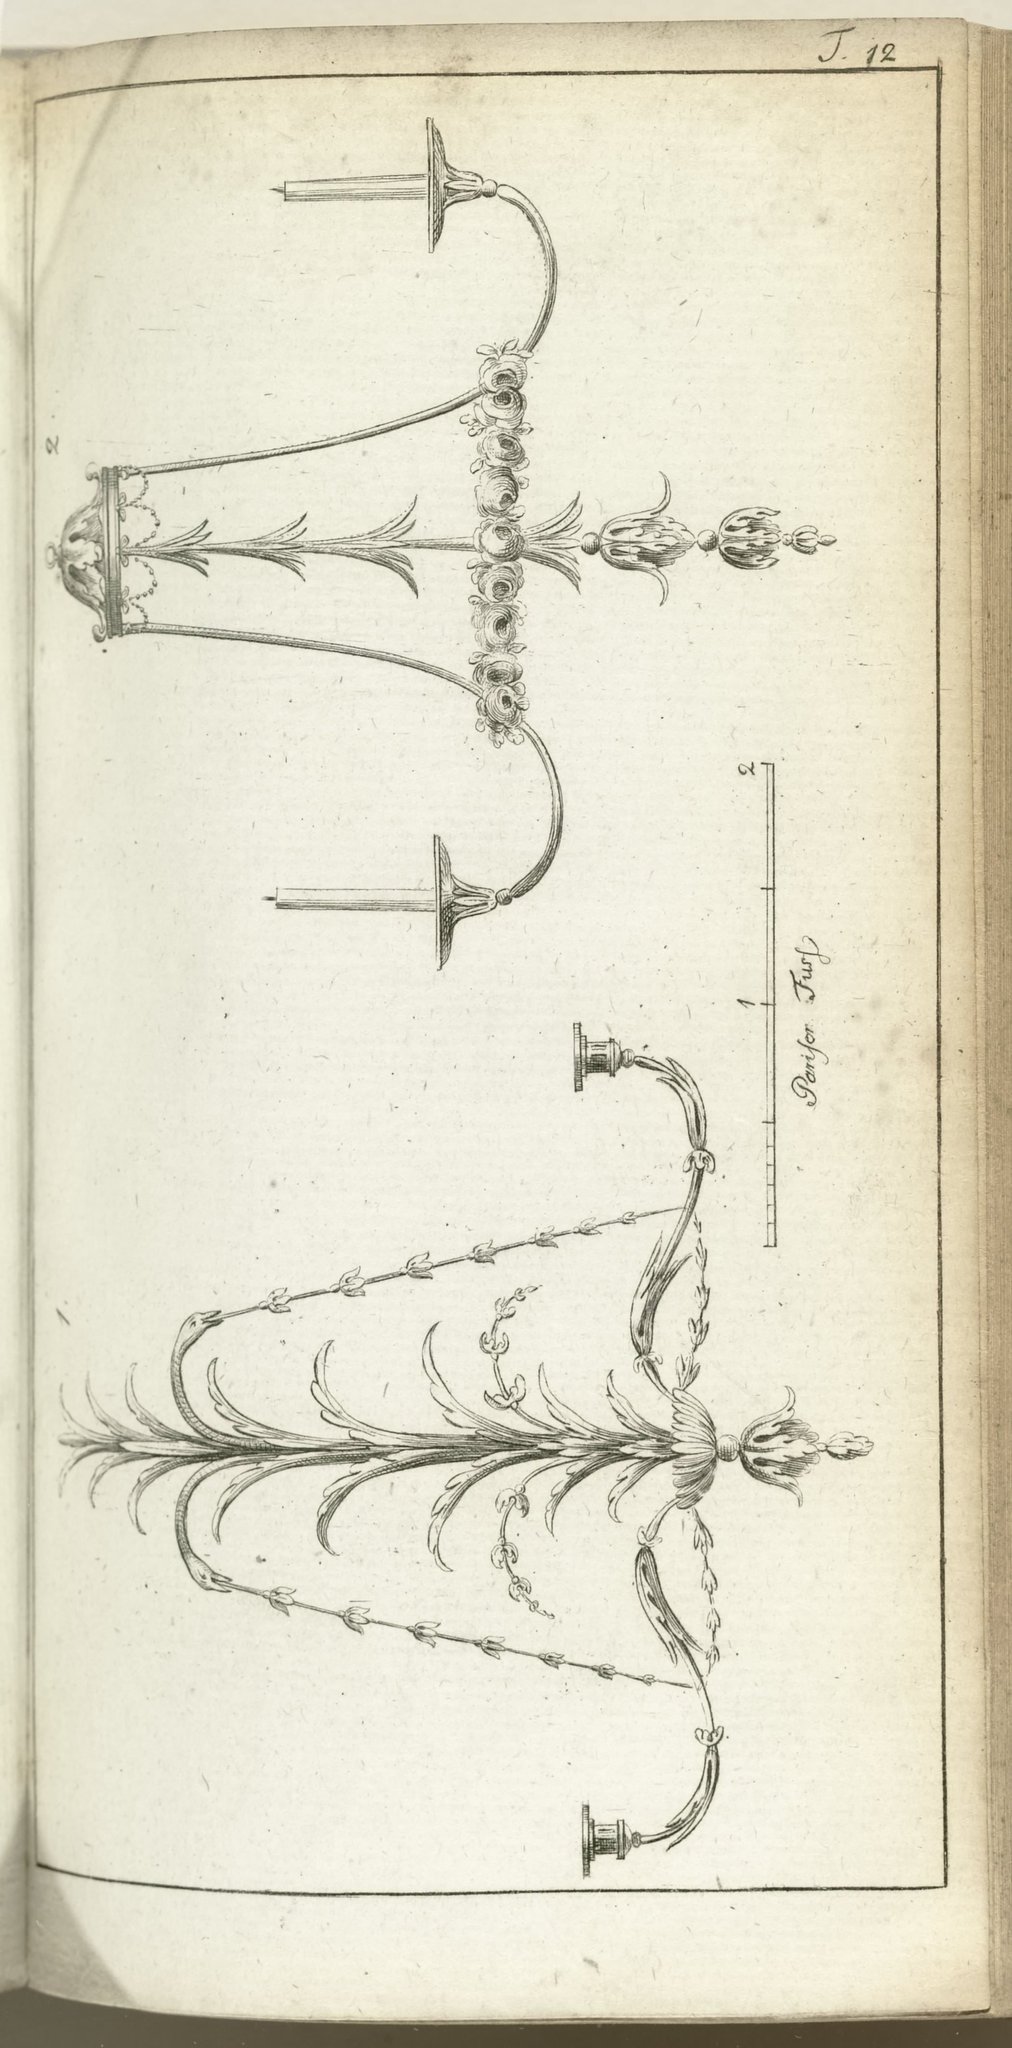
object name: magazine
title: Journal des Luxus und der Moden 1790, Band V, T.12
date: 1790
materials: paper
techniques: etching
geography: weimar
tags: fashion plates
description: Prent uit het modetijdschrift Journal des Luxus und der Moden, uitgegeven door Friedrich Justin Bertuch en Georg Melchior Kraus, Weimar, 1786-1826.